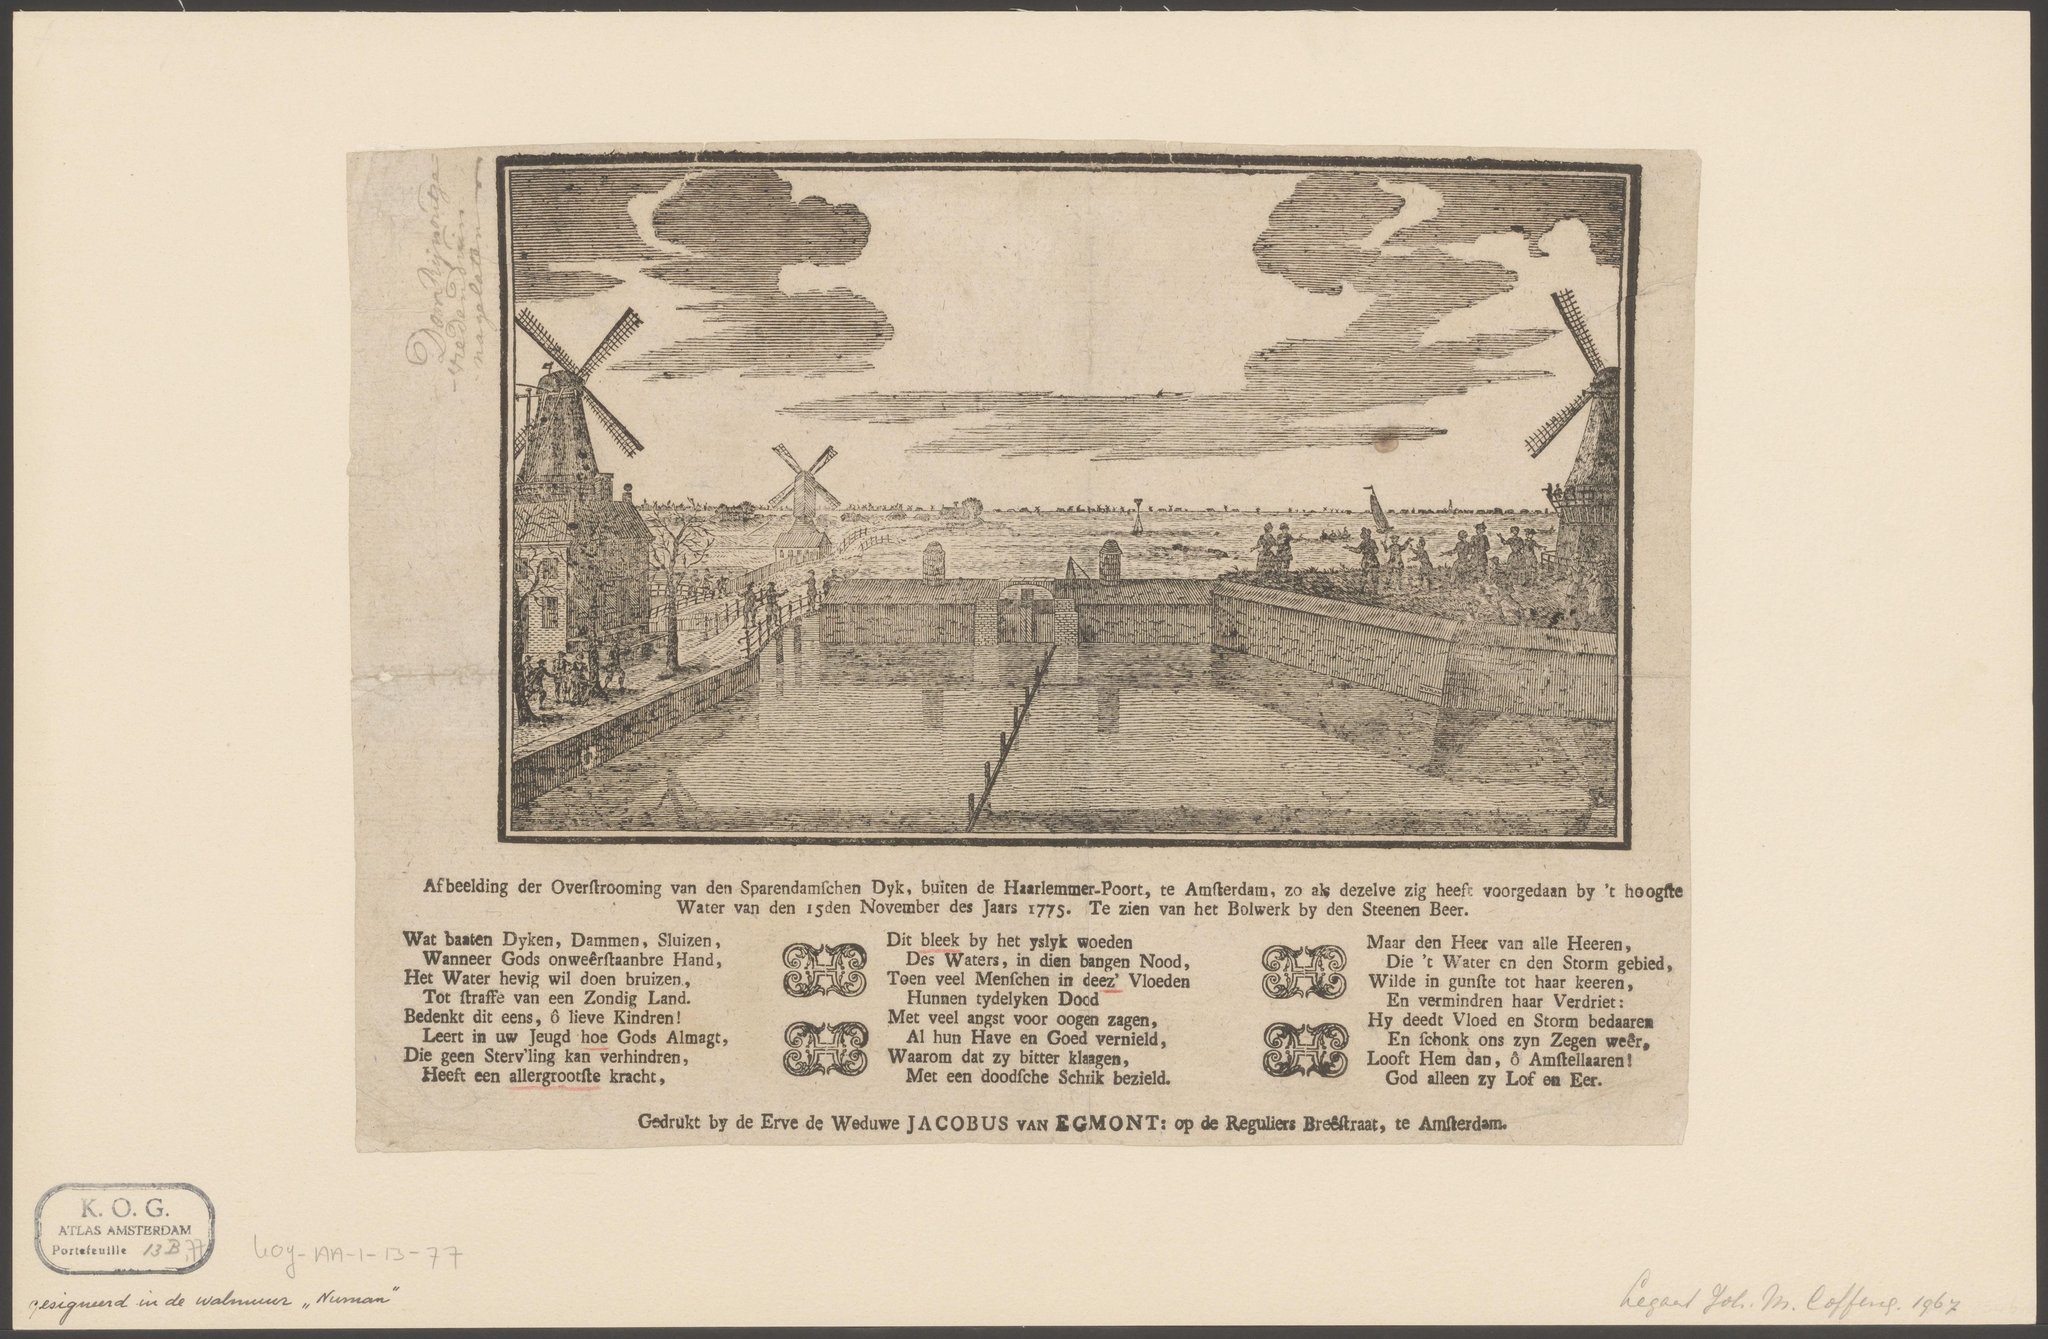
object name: print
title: Afbeelding der Overstrooming van den Sparendamschen Dyk, buiten de Haarlemmer-Poort, te Amsterdam (...)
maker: hendrik numan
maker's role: draughtsman, print maker, publisher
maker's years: 1736-1788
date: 1775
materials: paper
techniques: letterpress printing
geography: amsterdam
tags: city-view in general; 'veduta', windmill in landscape, flood, city-walls, the flood of 14-18 november 1775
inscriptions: inscription: ‘Door Rijnoutje / [...]redend[...] / nagelaten’, collector's mark: ‘13B,77’ Lugt 1641b, inscription: ‘gesigneerd in de walmuur "Numan" / Legaat Joh. M. Coffeng. 1967’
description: Onderwerpsrubriek binnen de Atlas Amsterdam: Slatuinenpad, Sloterkade, Slootstraat, Slijkstraat, Snoekjesgracht, Sophiapark, Spaarndammerdijk, Spiegelgracht, Spinhuissteeg, Spui, Spuistraat (ook lage Erf), Staalstraat, Stadhouderskade, Steenpad, Stroomarkt.